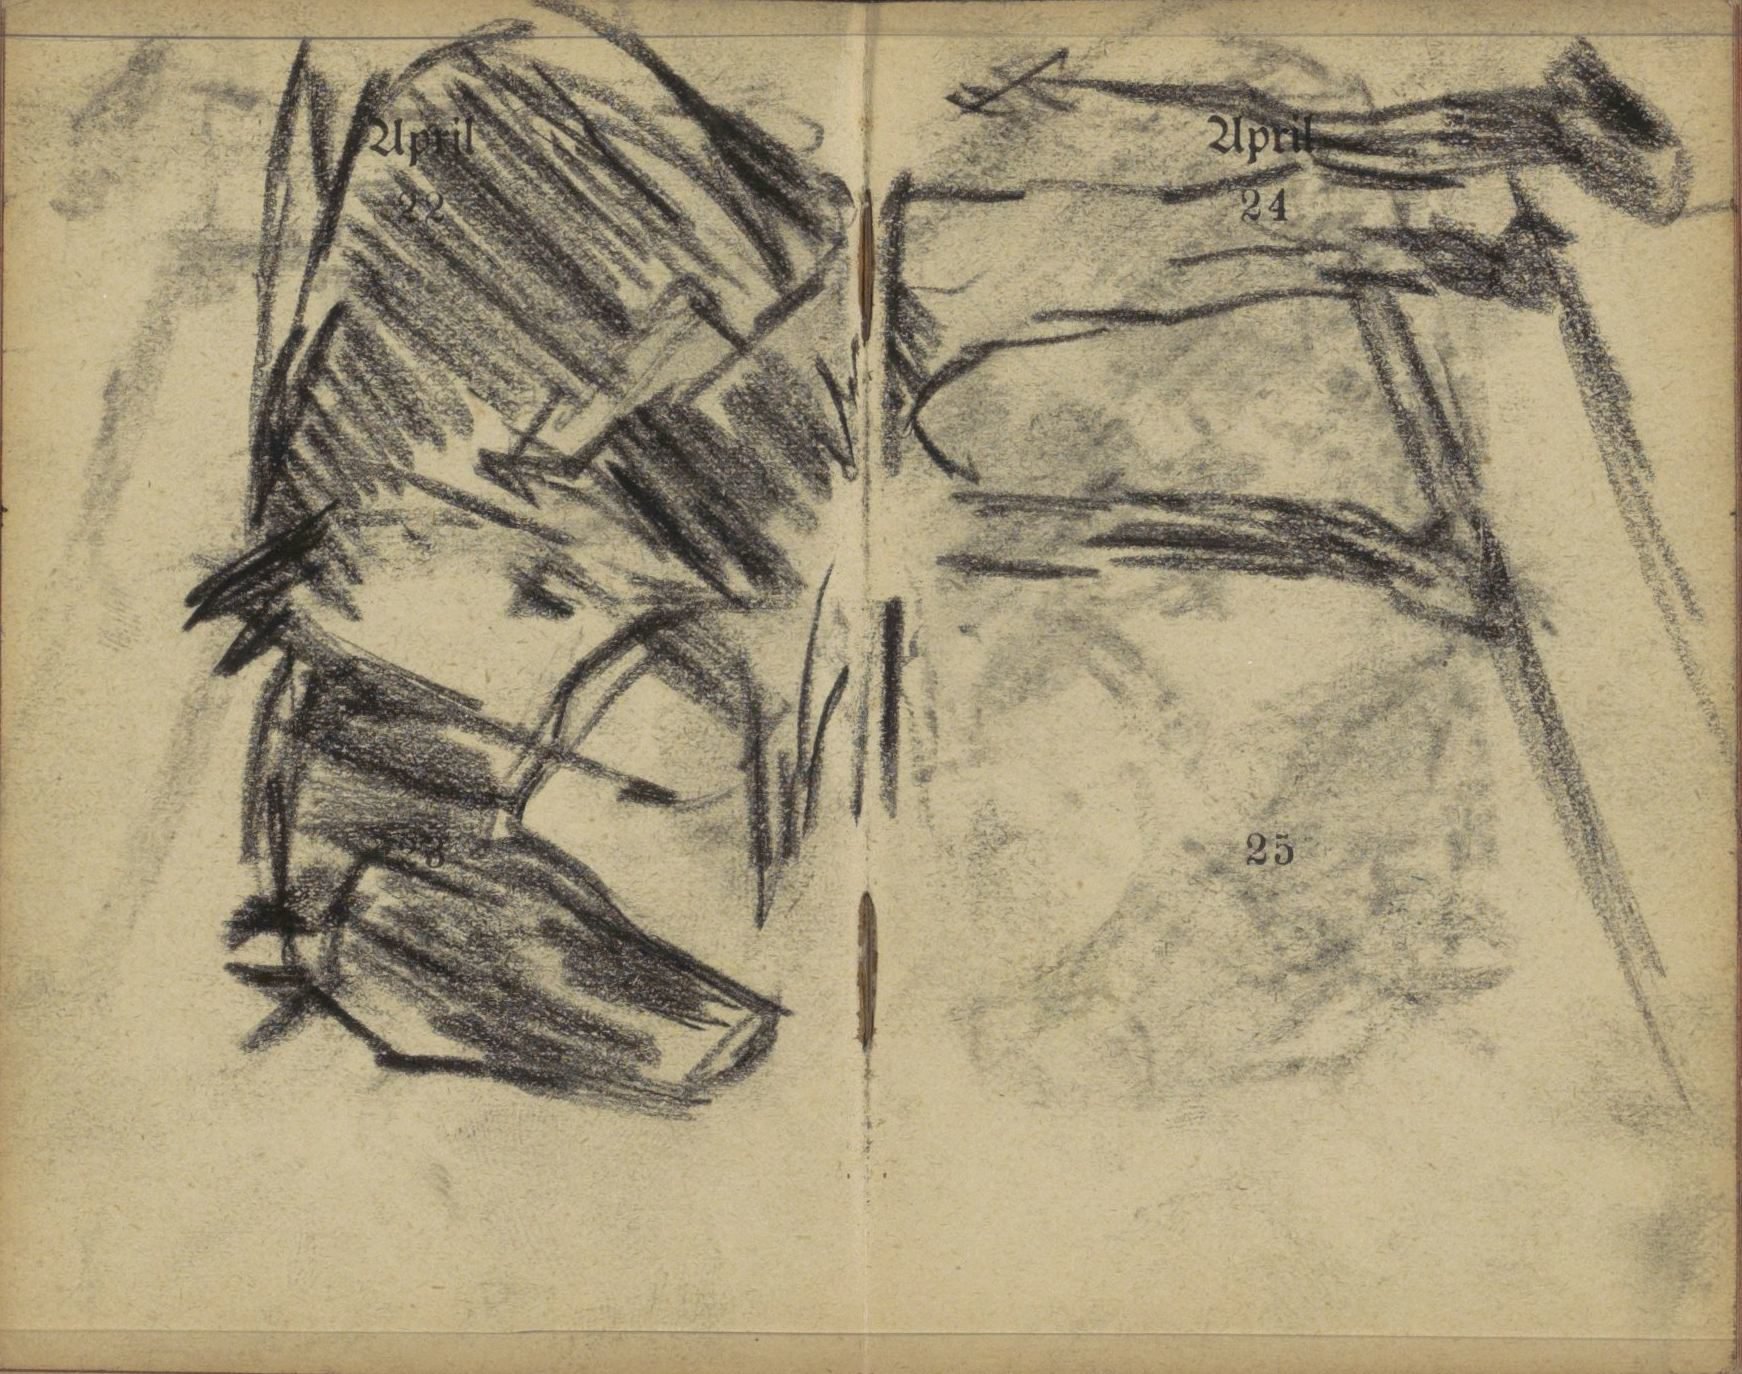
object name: sketchbook leaf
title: Twee paarden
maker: george hendrik breitner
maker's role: draughtsman, painter, print maker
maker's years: 1857-1923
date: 1893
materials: chalk, paper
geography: amsterdam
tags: horse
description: Pagina 61 en pagina 62 uit een als schetsboek gebruikte agenda met 80 bladen.